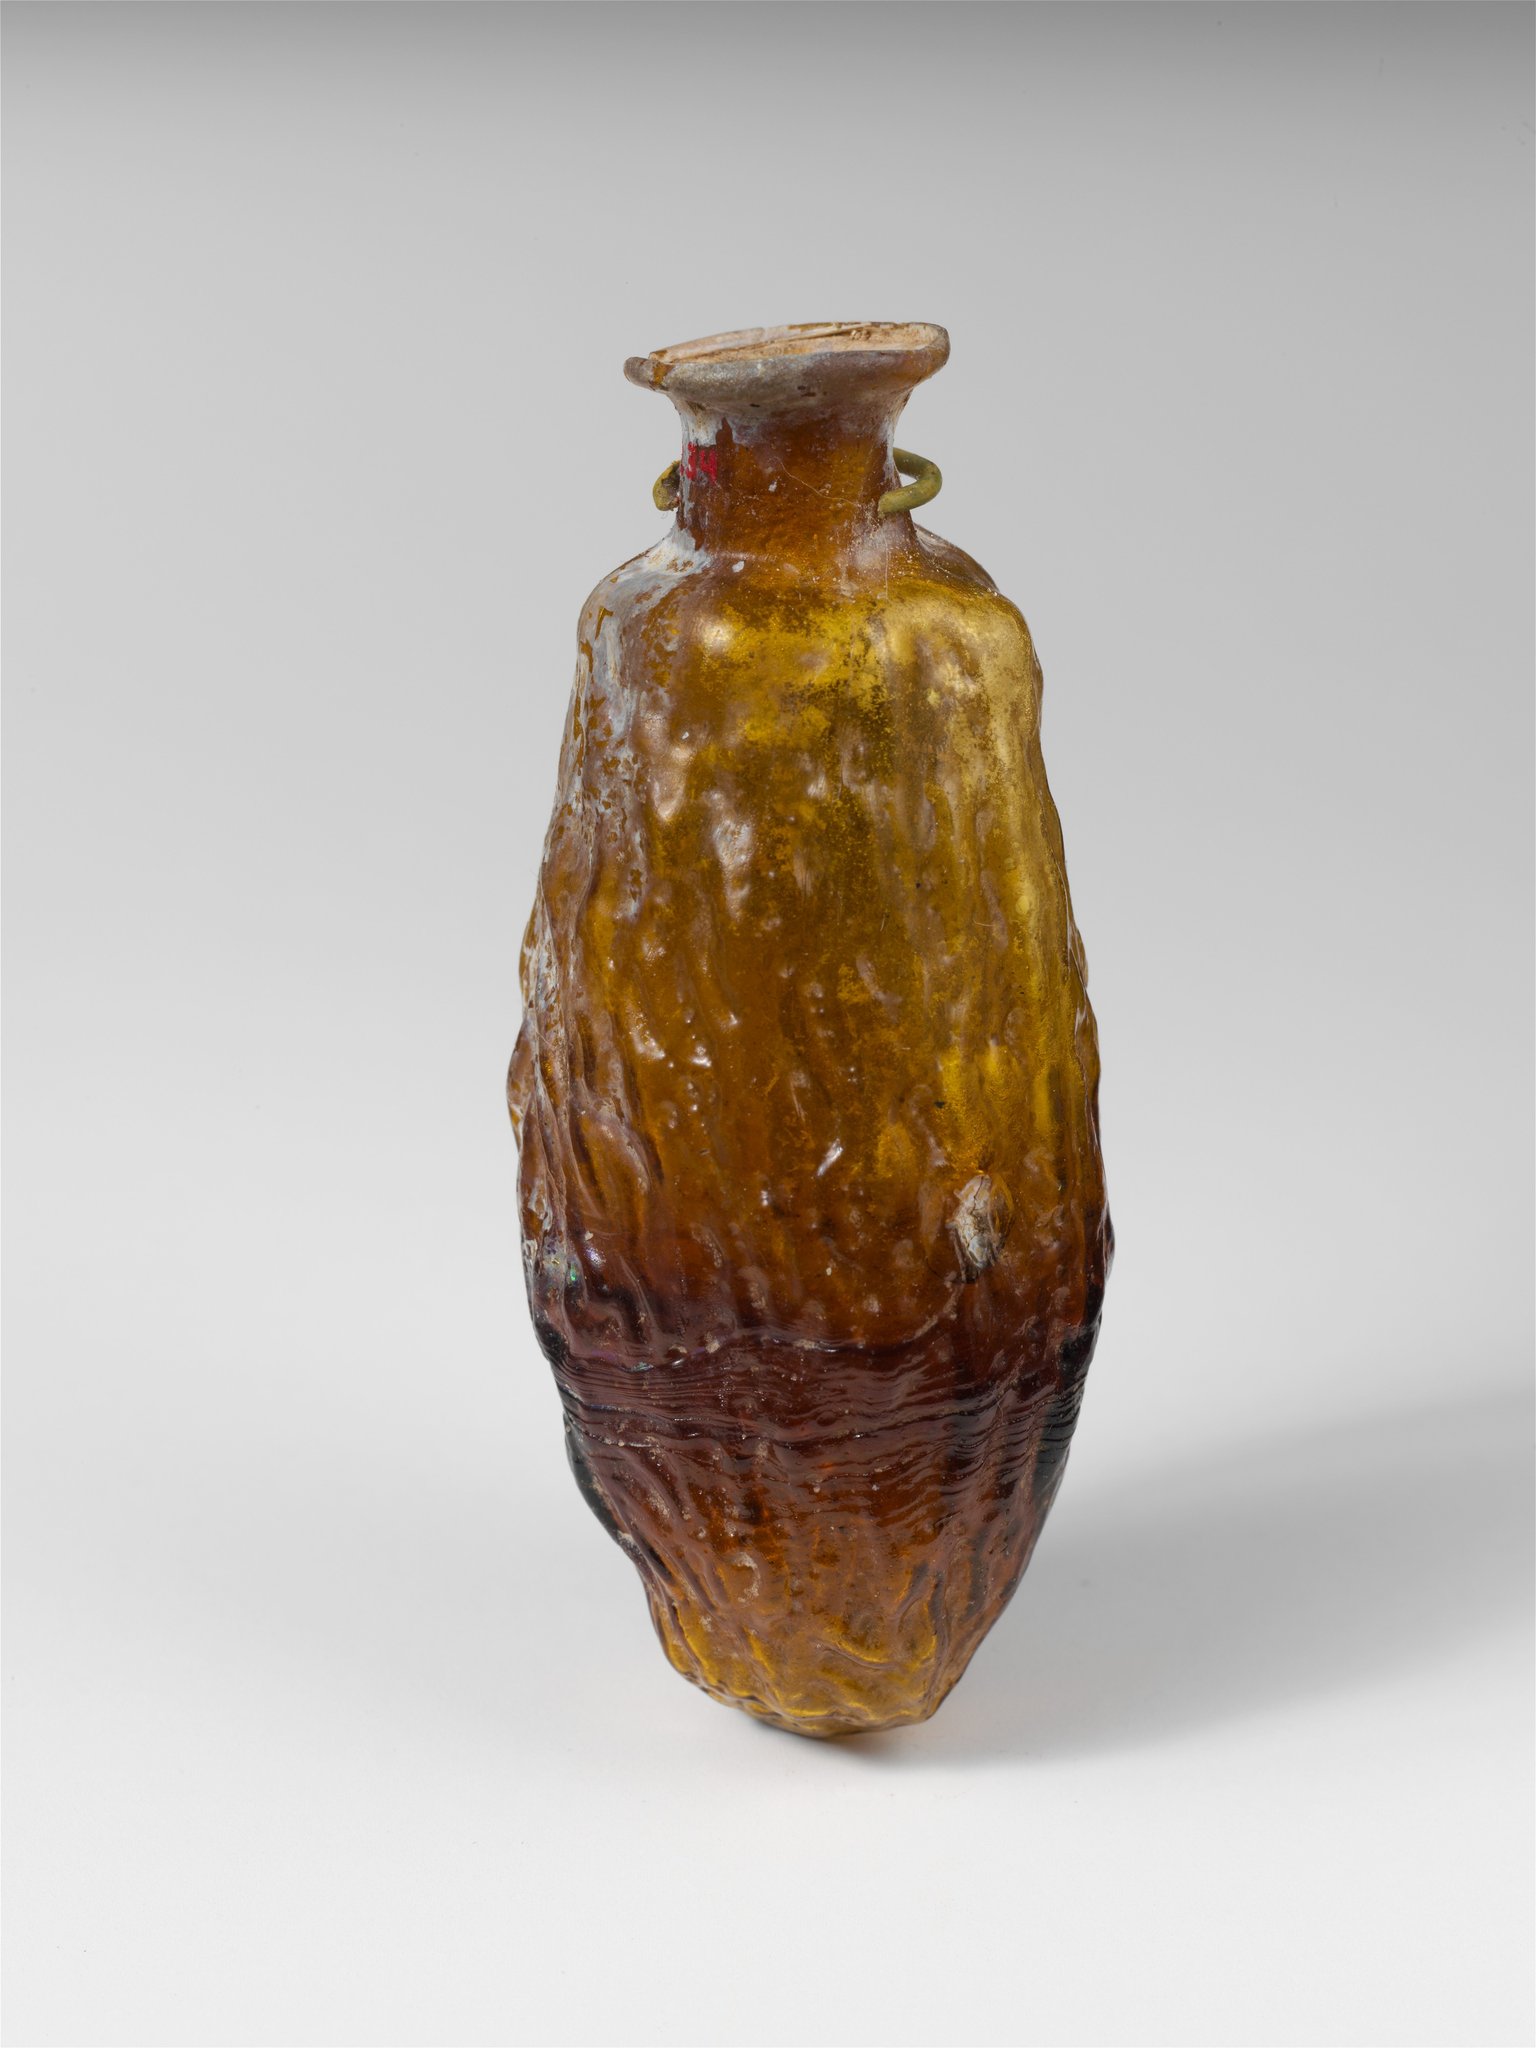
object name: flask in the form of a date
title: Glass bottle shaped like a date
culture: roman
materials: glass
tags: fruit